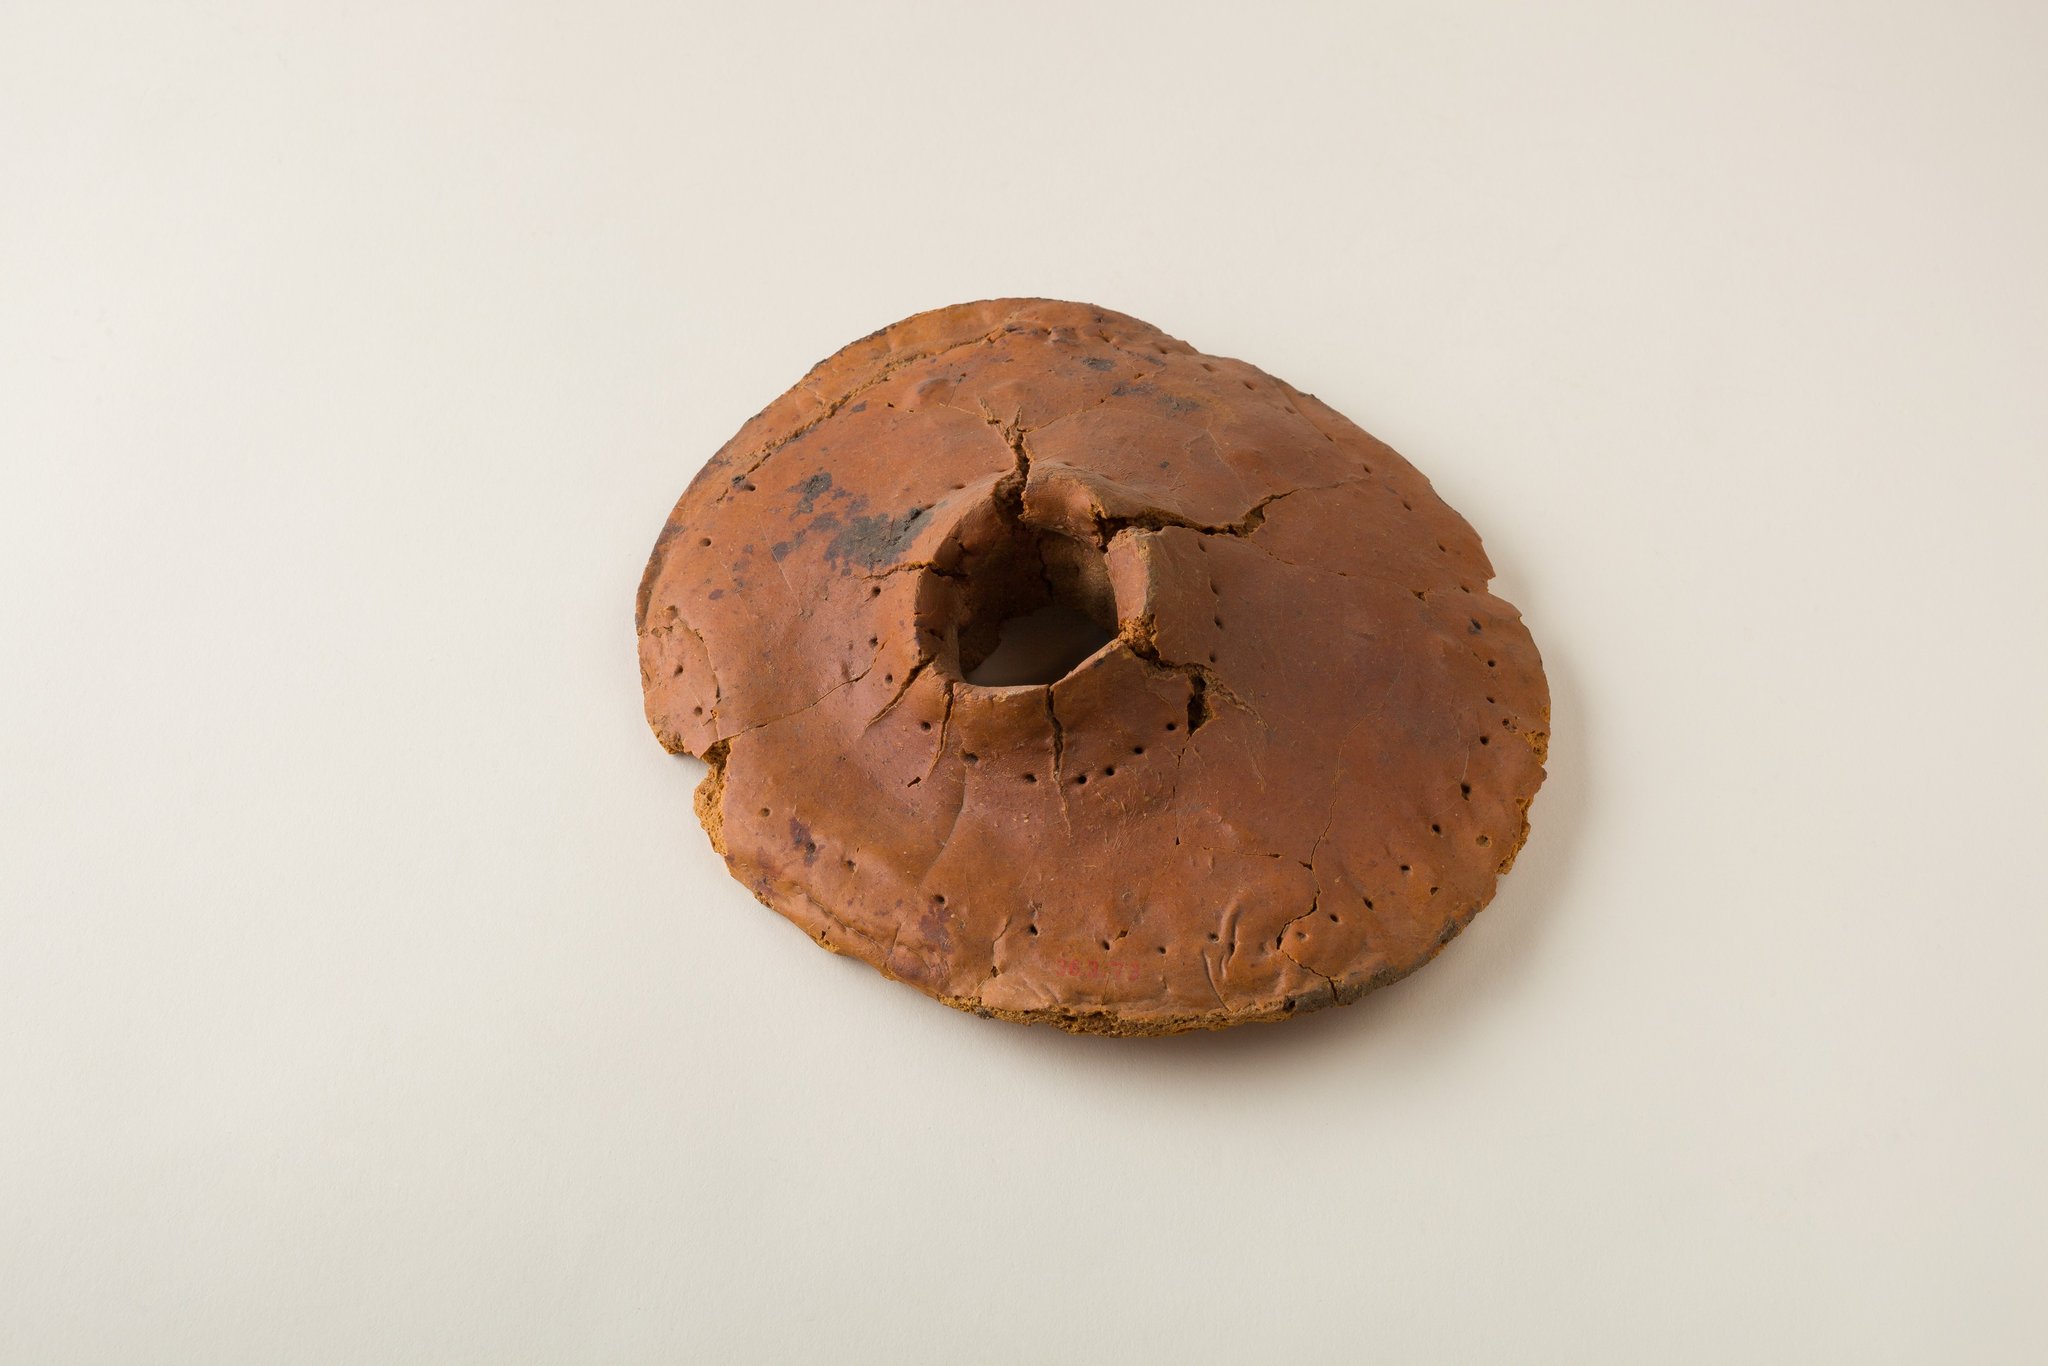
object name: food, bread, round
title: Loaf of Bread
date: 1492-1473 BCE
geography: egypt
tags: bread